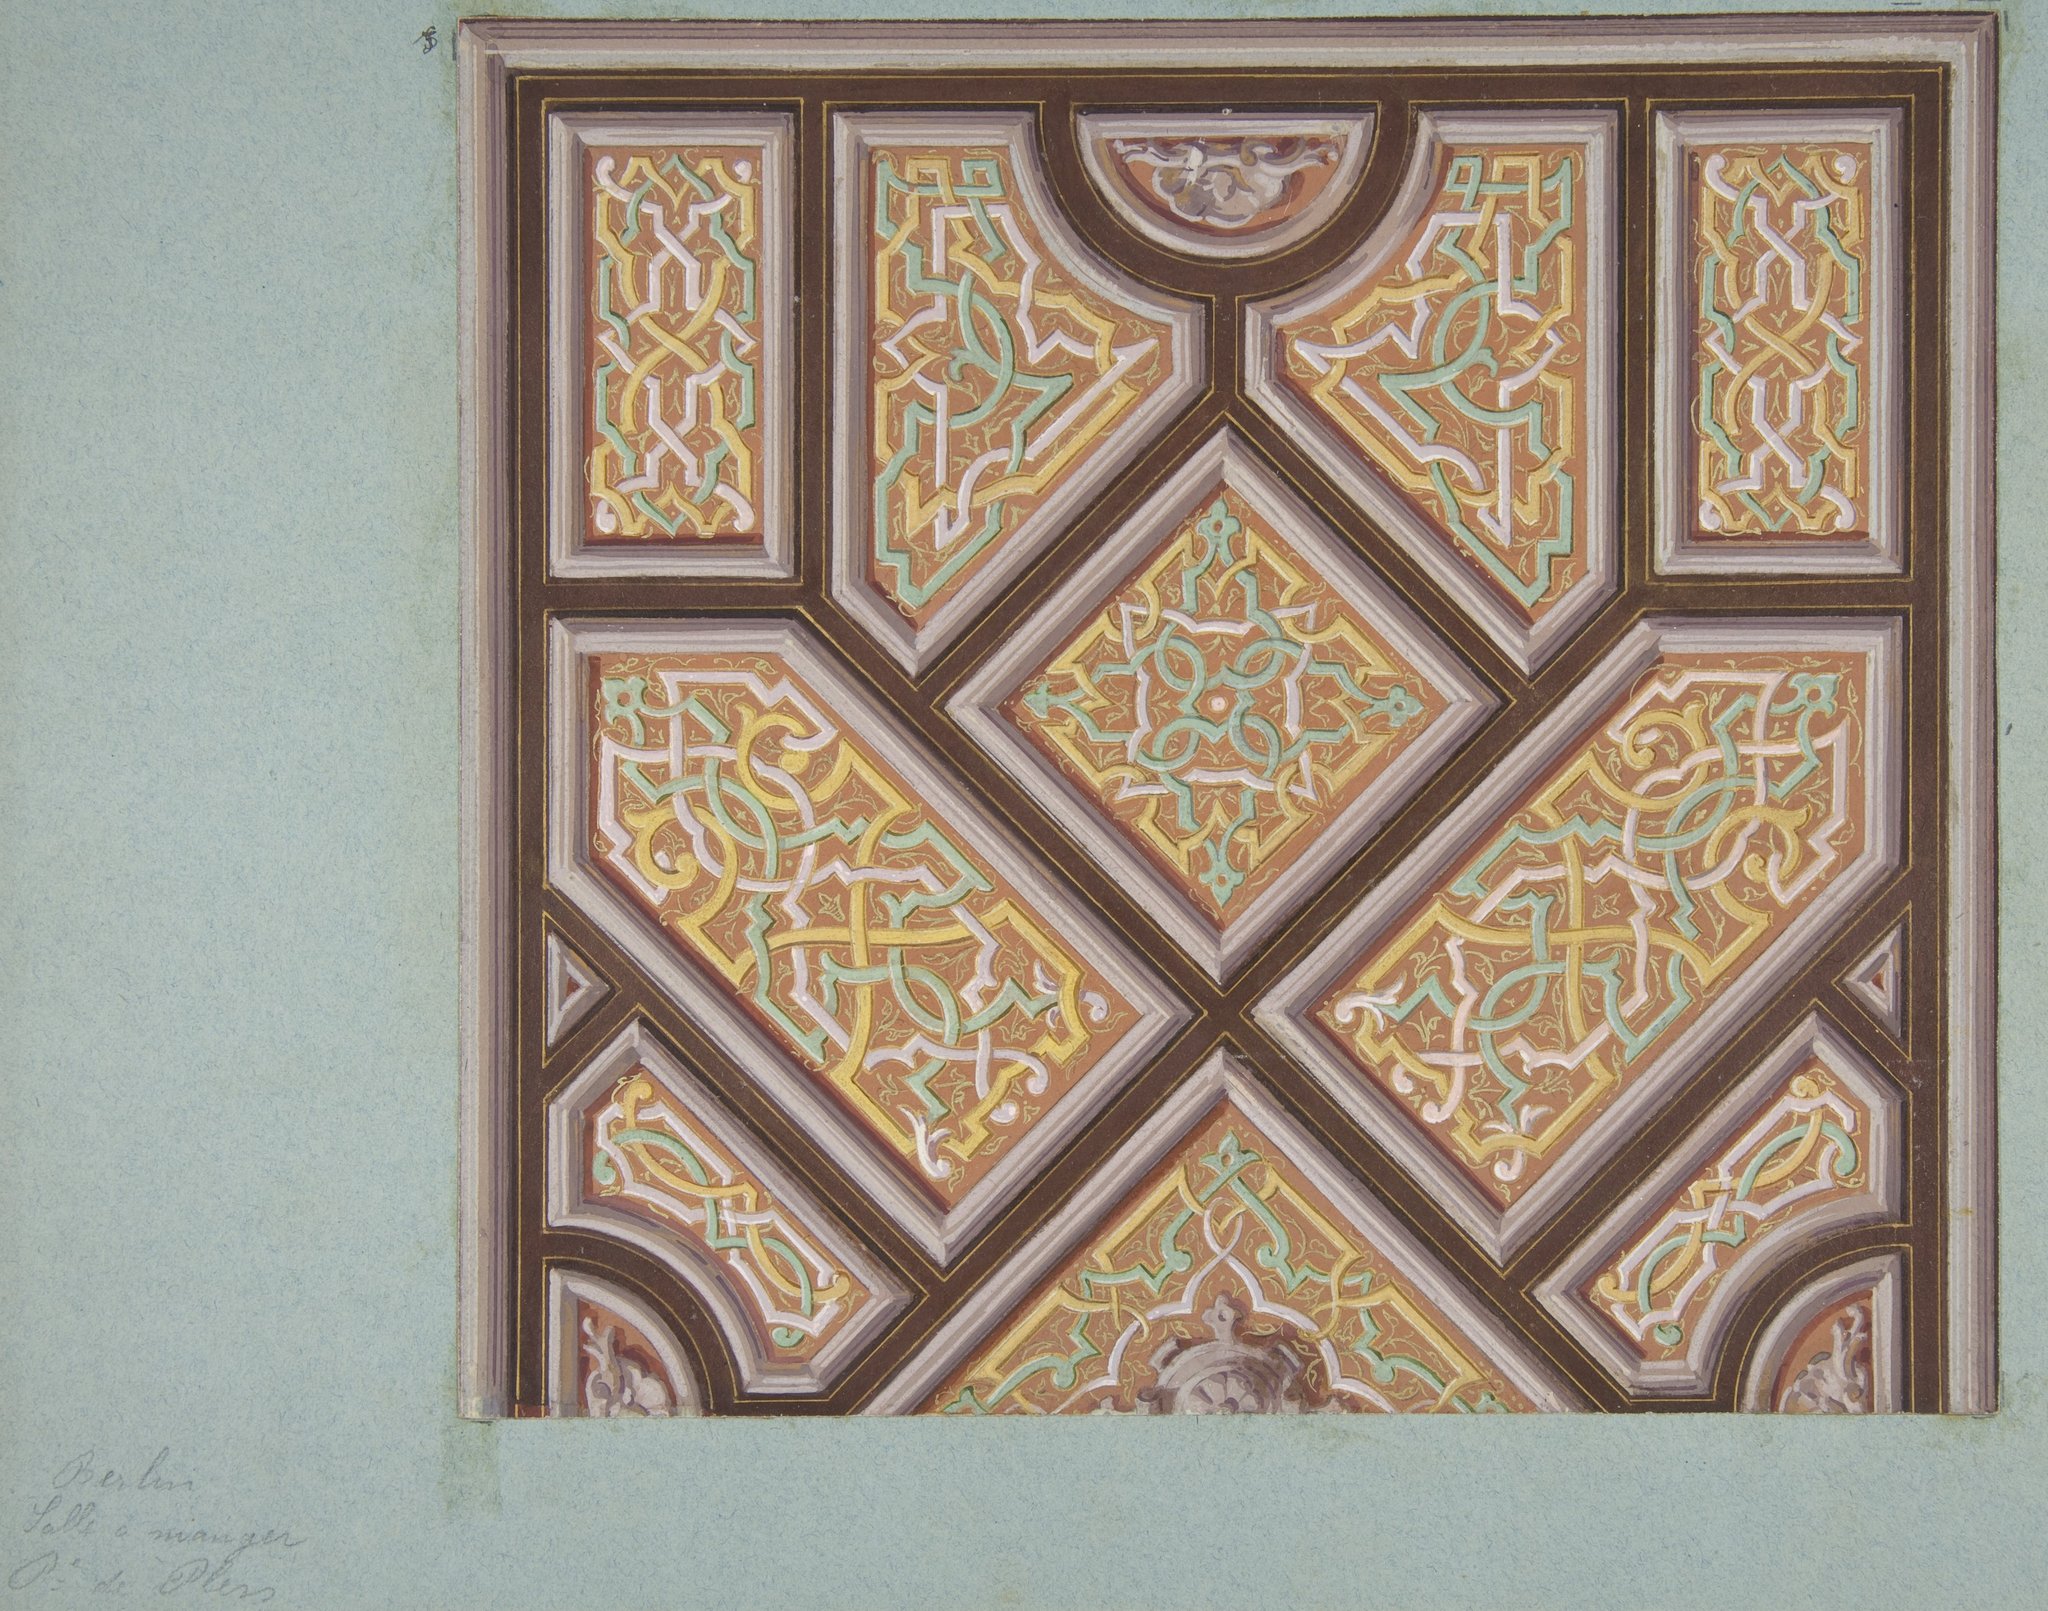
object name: drawing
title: Design for Ceiling Decoration in the Dining Room, Hôtel de Pless, Berlin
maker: jules-edmond-charles lachaise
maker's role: artist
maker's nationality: french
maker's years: 1897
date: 1851-1900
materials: gold paint, gouache, watercolor, paper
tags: ceilings